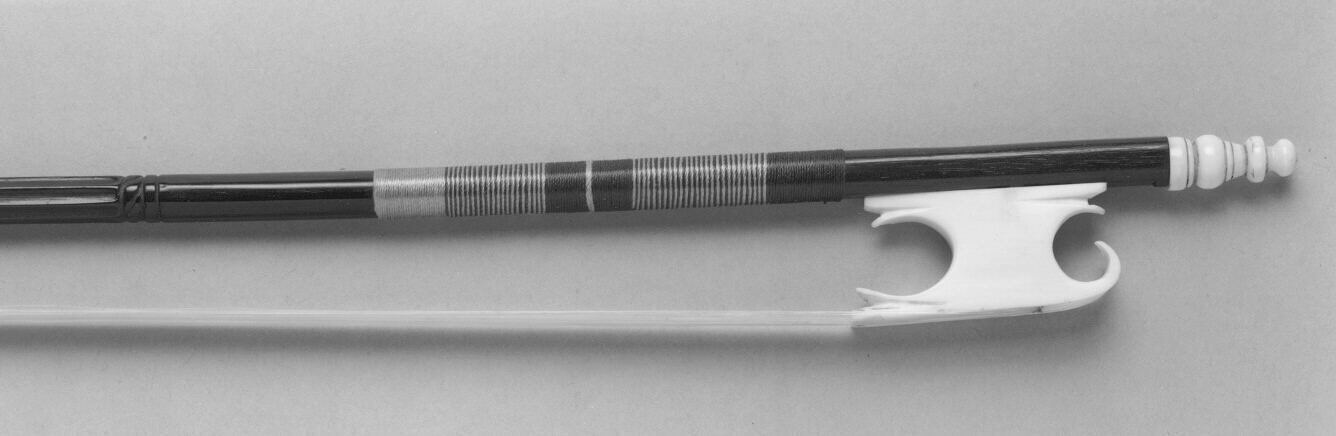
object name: violin bow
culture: european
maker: amsterdam school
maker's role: maker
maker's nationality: dutch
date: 1740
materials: hair, ivory